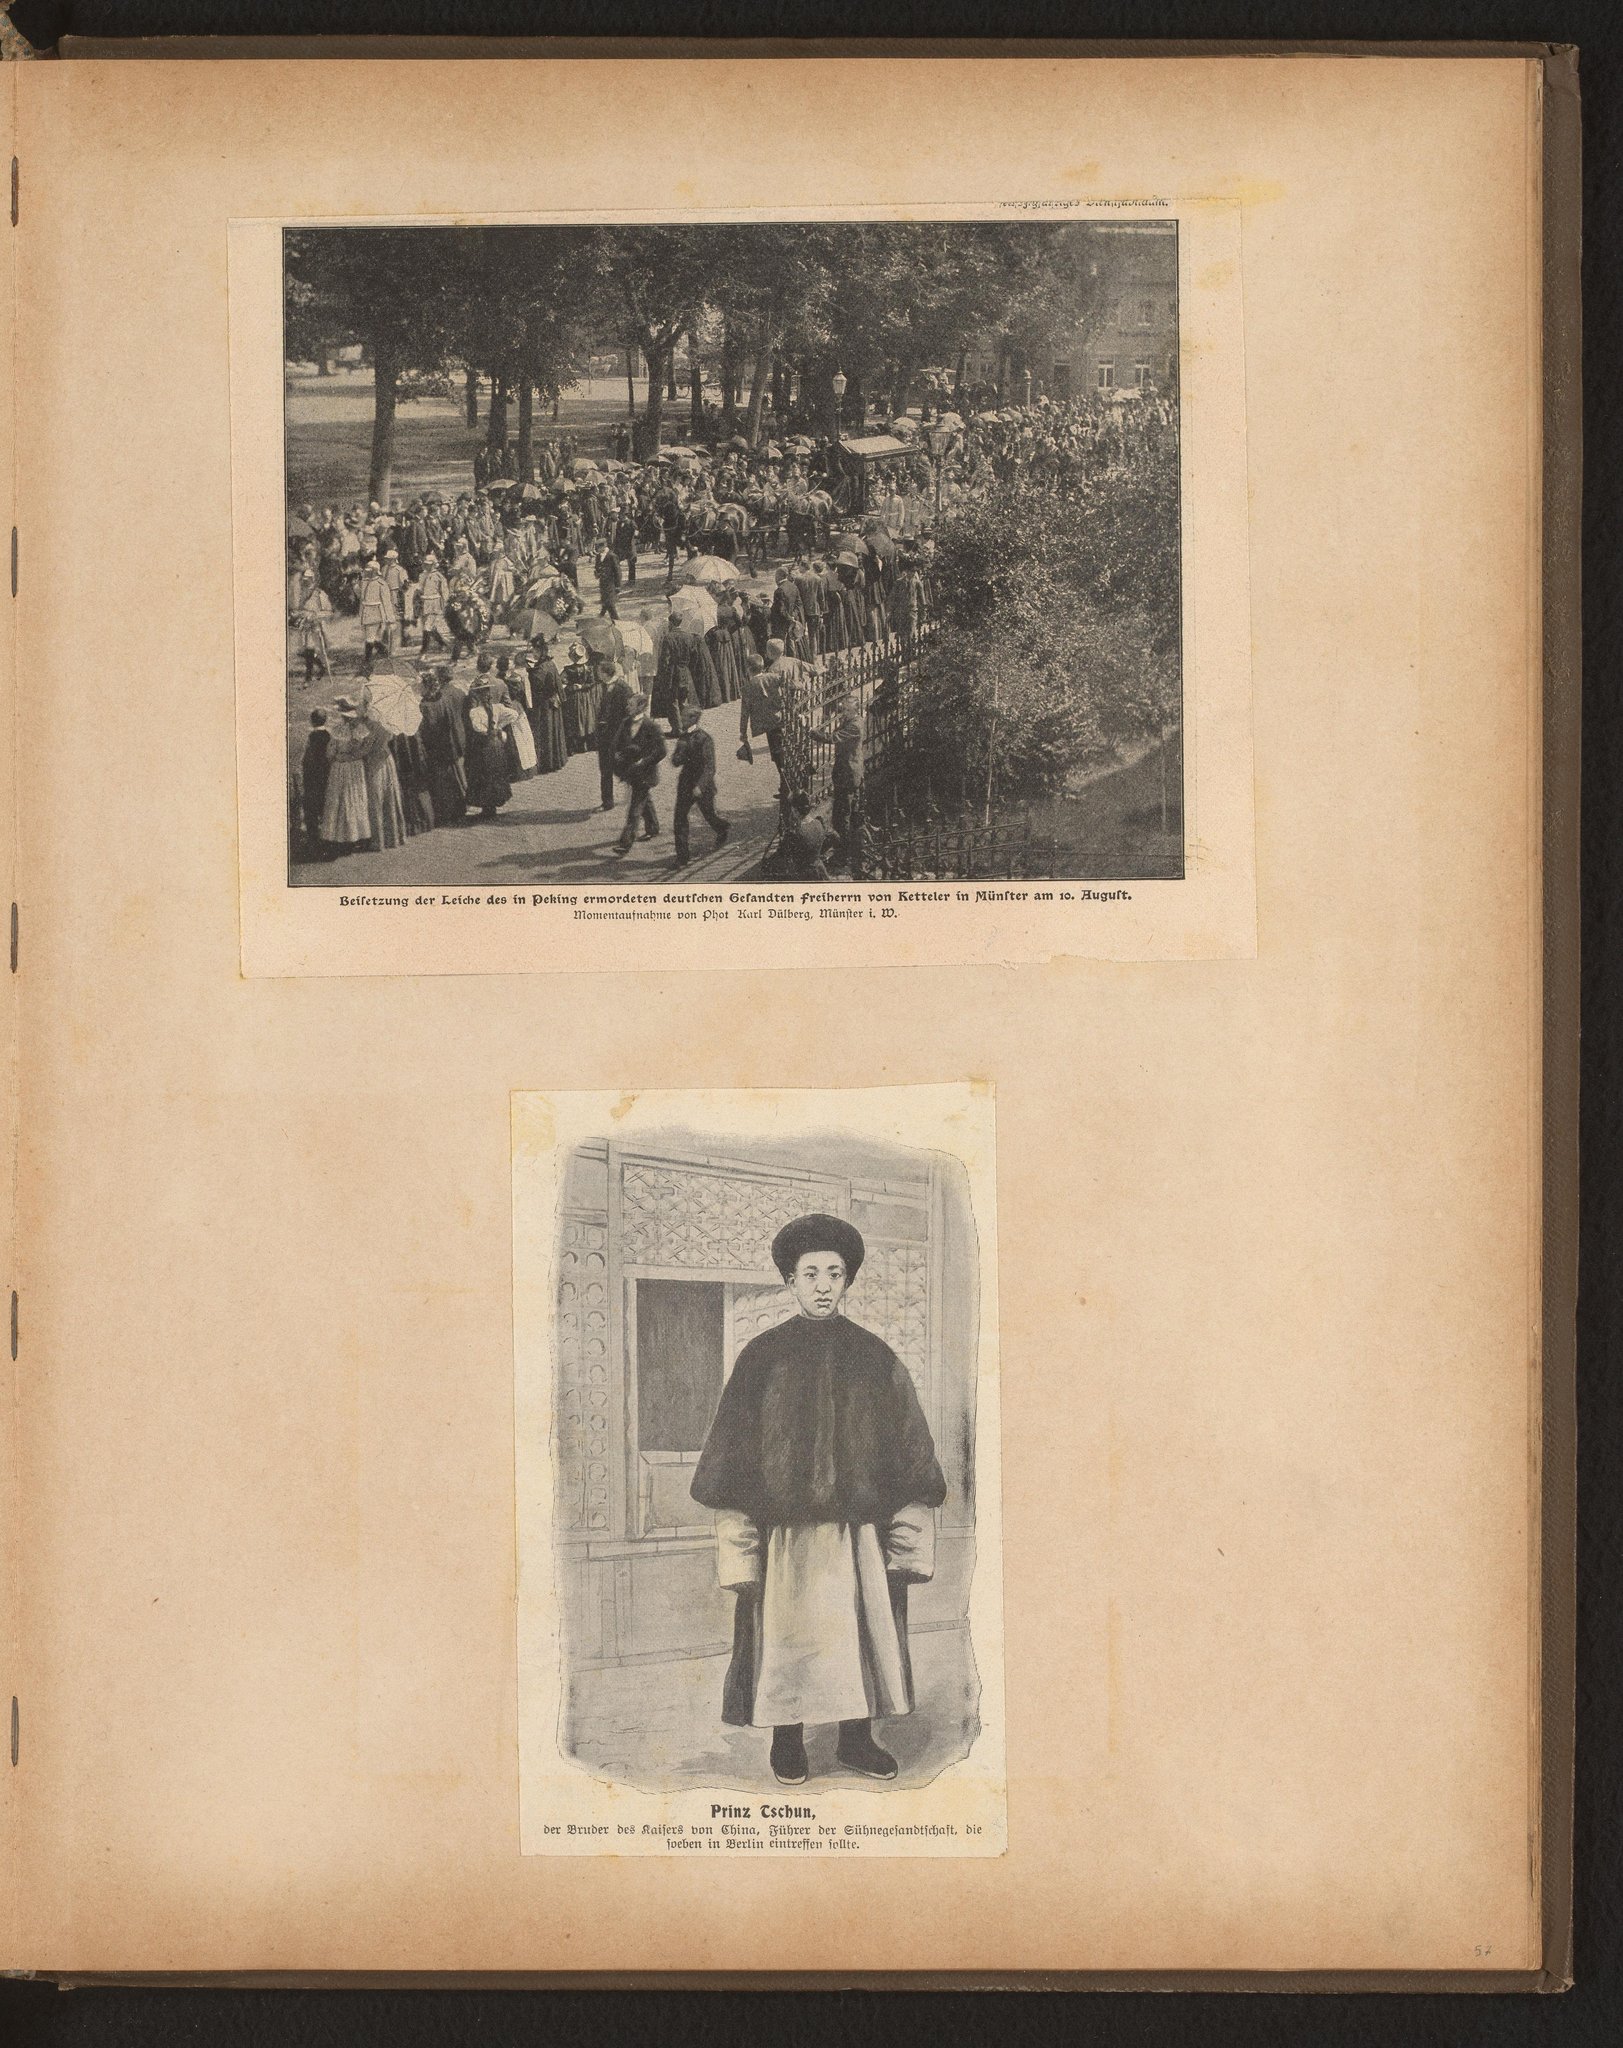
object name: album leaf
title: Rouwstoet voor de begrafenis van Clemens von Kettler en een reproductie van een getekend portret van Aisin Gioro Zaifeng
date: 1901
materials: paper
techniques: autotype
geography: homburg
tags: historical persons, public funeral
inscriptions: inscription: ‘Beisetzung der Leiche des in Peking ermordeten deutschen Gesandten Freiherrn von Ketteler in Münster am 10. August./ Momentaufnahme von Phot. Karl Dülberg, Münster i. W.’, inscription: ‘Prinz Tschun,/ der Bruder des Kaisers von China, Führer der Sühnegesandtschaft, die/ soeben in Berlin eintreffen sollte.’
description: Deze fotomechanische afdrukken maken deel uit van een album.